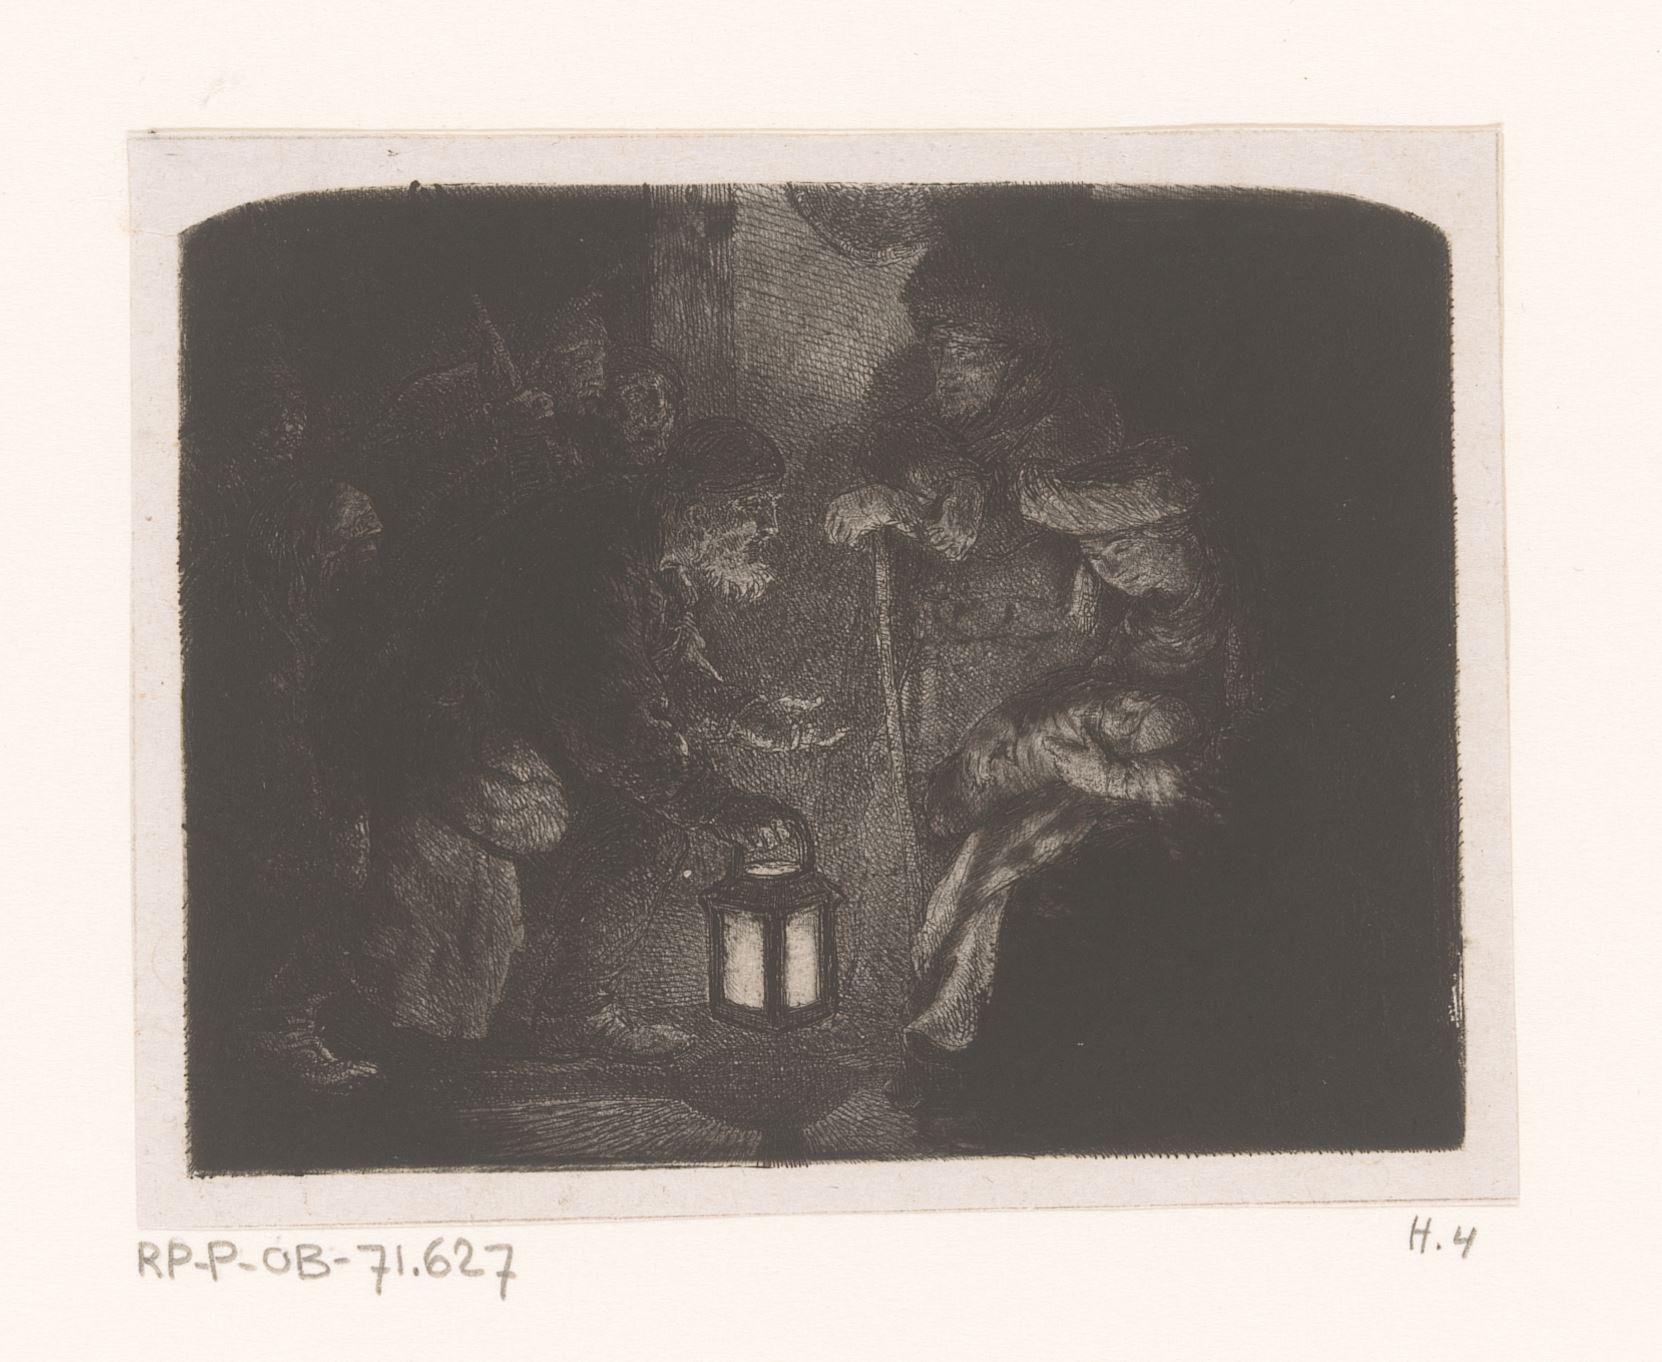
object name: print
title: Aanbidding door de herders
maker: jean pierre norblin de la gourdaine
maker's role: print maker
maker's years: 1745-1830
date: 1755-1830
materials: paper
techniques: drypoint, etching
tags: adoration of the christ-child by the shepherds; mary and joseph present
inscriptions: collector's mark: Lugt 2228